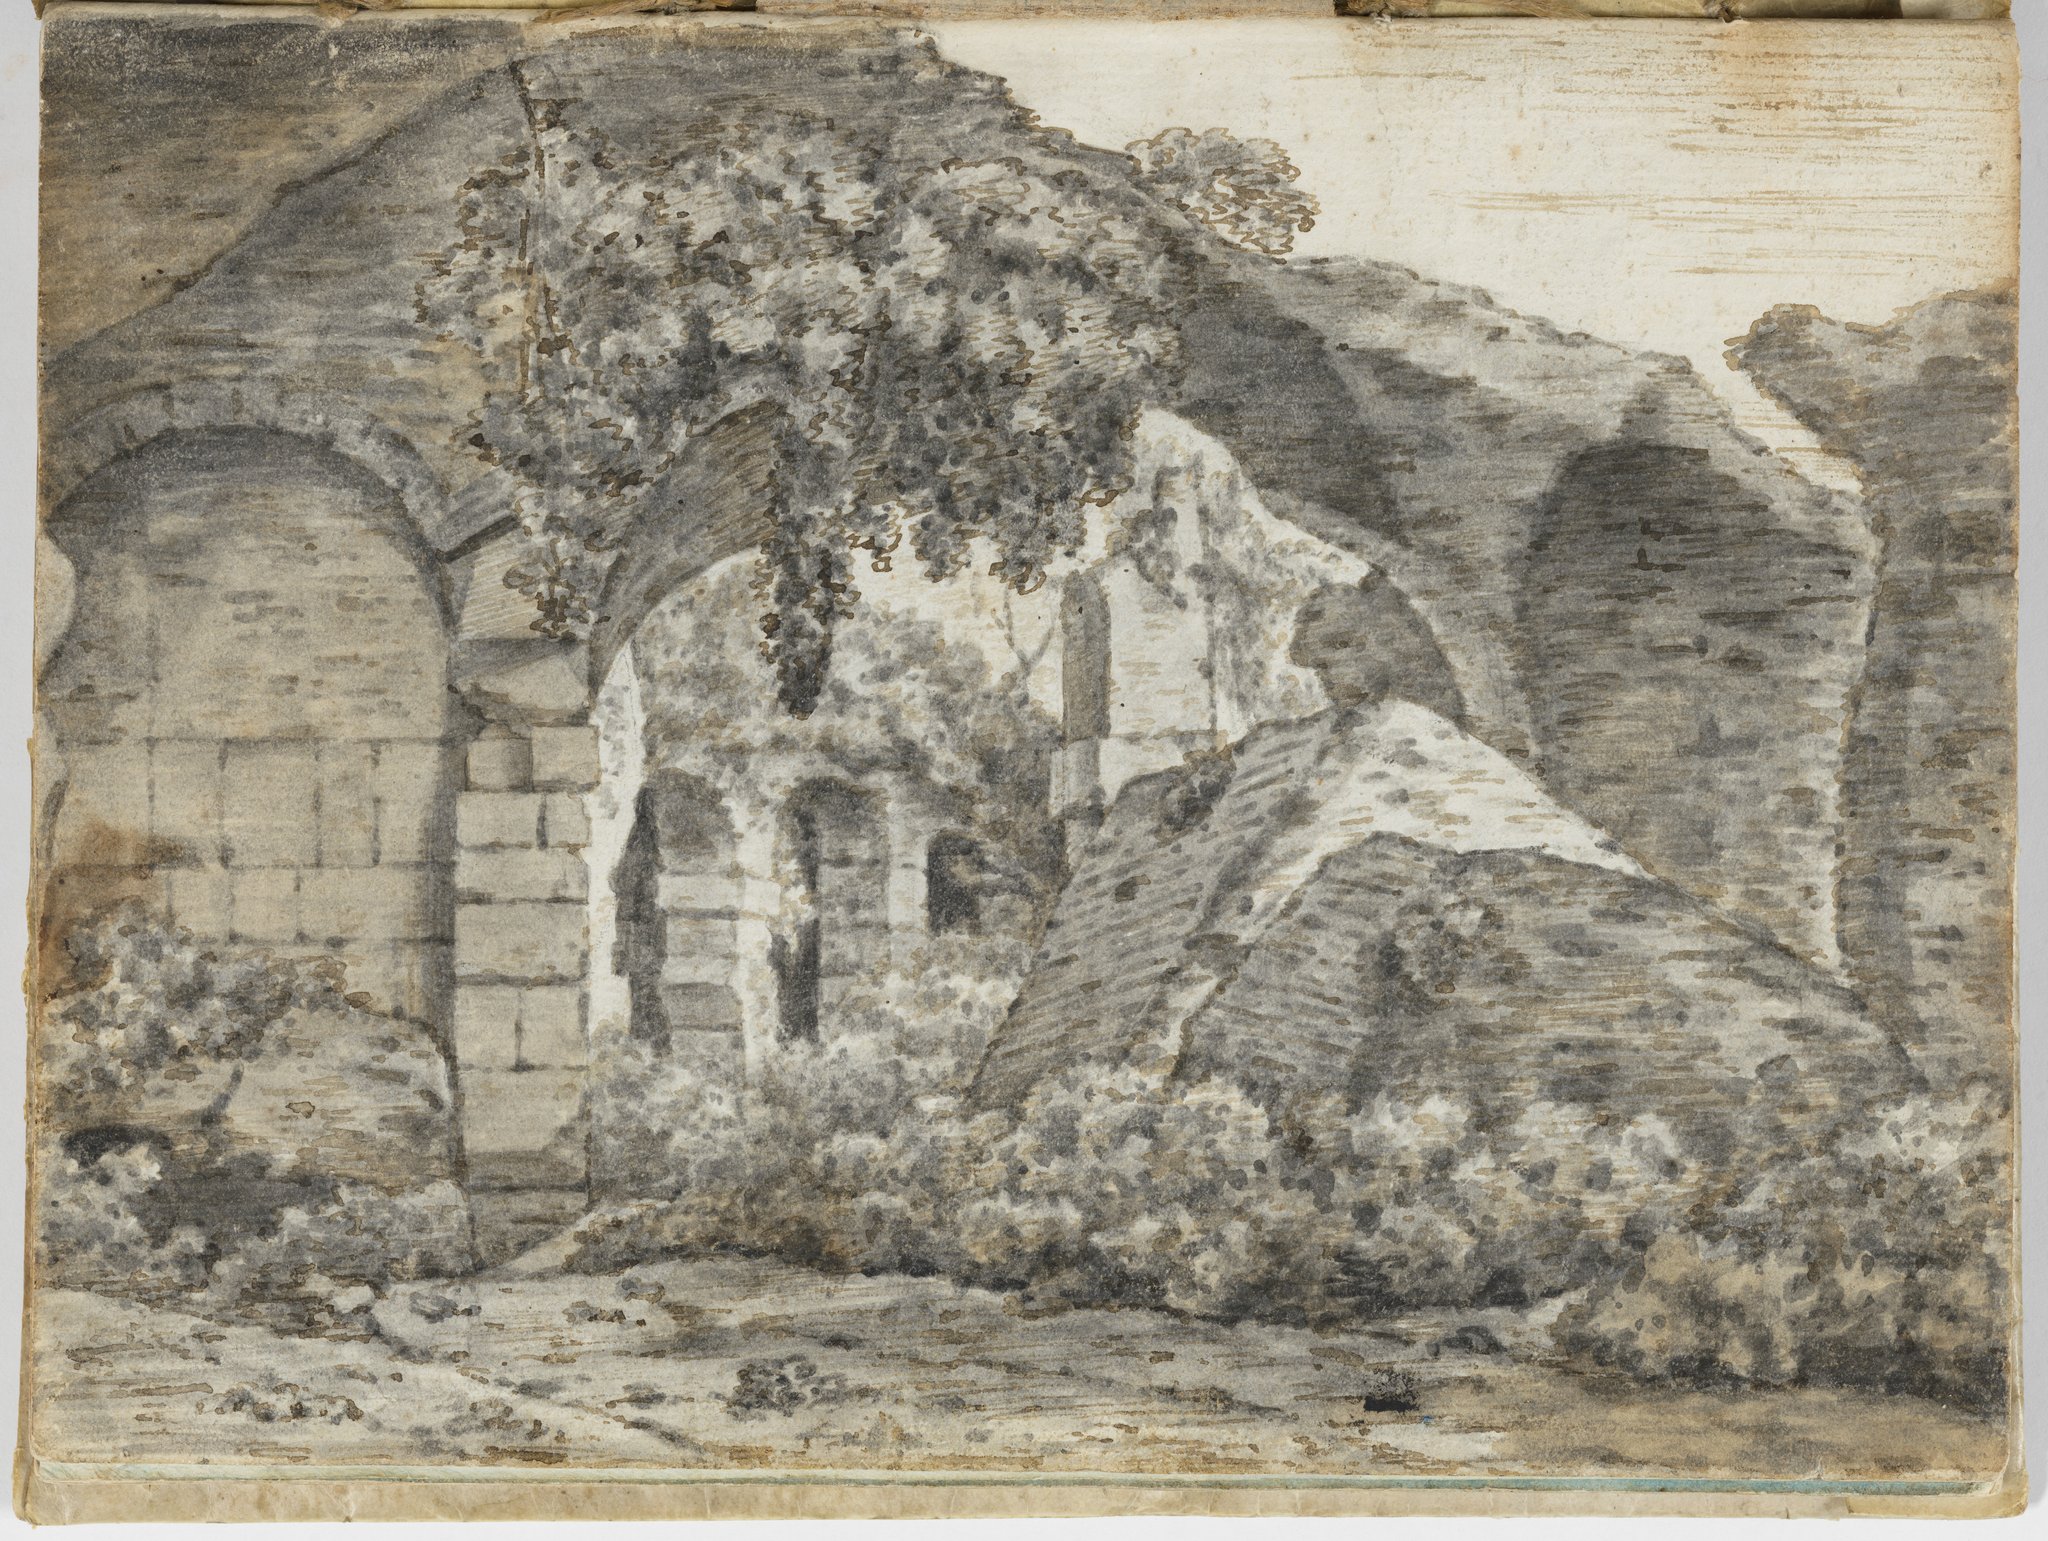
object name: drawing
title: Roman ruins (recto). Three figures in classical robes (verso) (Smaller Italian sketchbook, leaf 1)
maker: joseph wright (wright of derby)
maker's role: artist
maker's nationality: british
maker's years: 1734-1797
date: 1774-1775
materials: graphite, ink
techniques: brush, pen, wash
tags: ruins